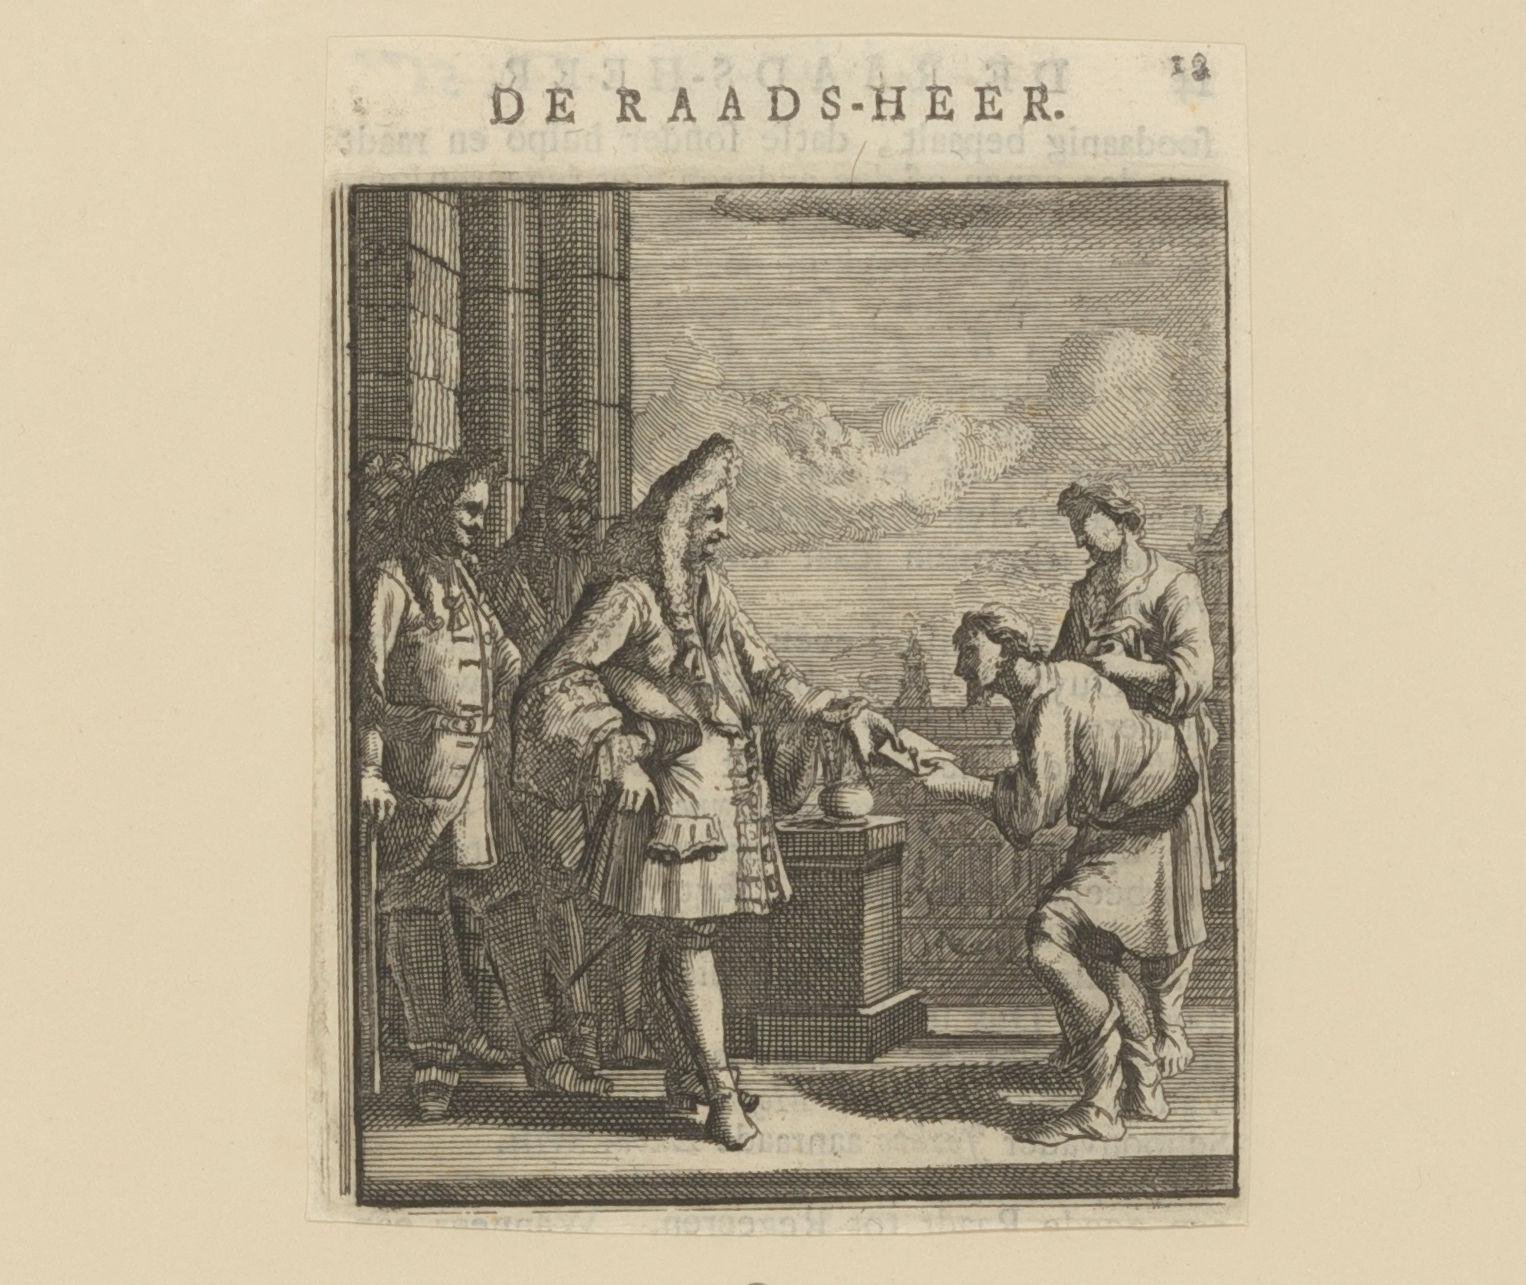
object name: print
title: De Raads-heer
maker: Anonymous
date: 1719-1759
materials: paper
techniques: etching, letterpress printing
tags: magistracy, judges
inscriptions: stamp, collector's mark: Lugt 1641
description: Prent met andere letterzetting gebruikt in: St. Clara, Abraham van. Iets voor allen. [Vertaald door] J. le Long. Amsterdam: Janssoons van Waesberge, 1719, dl. 2. En in: St. Clara, Abraham van. Iets voor allen. [Vertaald door] J. le Long. Amsterdam: Jan Roman de Jonge, 1741, dl. 2. En in: St. Clara, Abraham van. Iets voor allen. [Vertaald door] J. le Long. Amsterdam: Jan Roman, 1759, dl. 2. Huidige prent uit een andere editie. Naar een prent van: Jan Luyken.